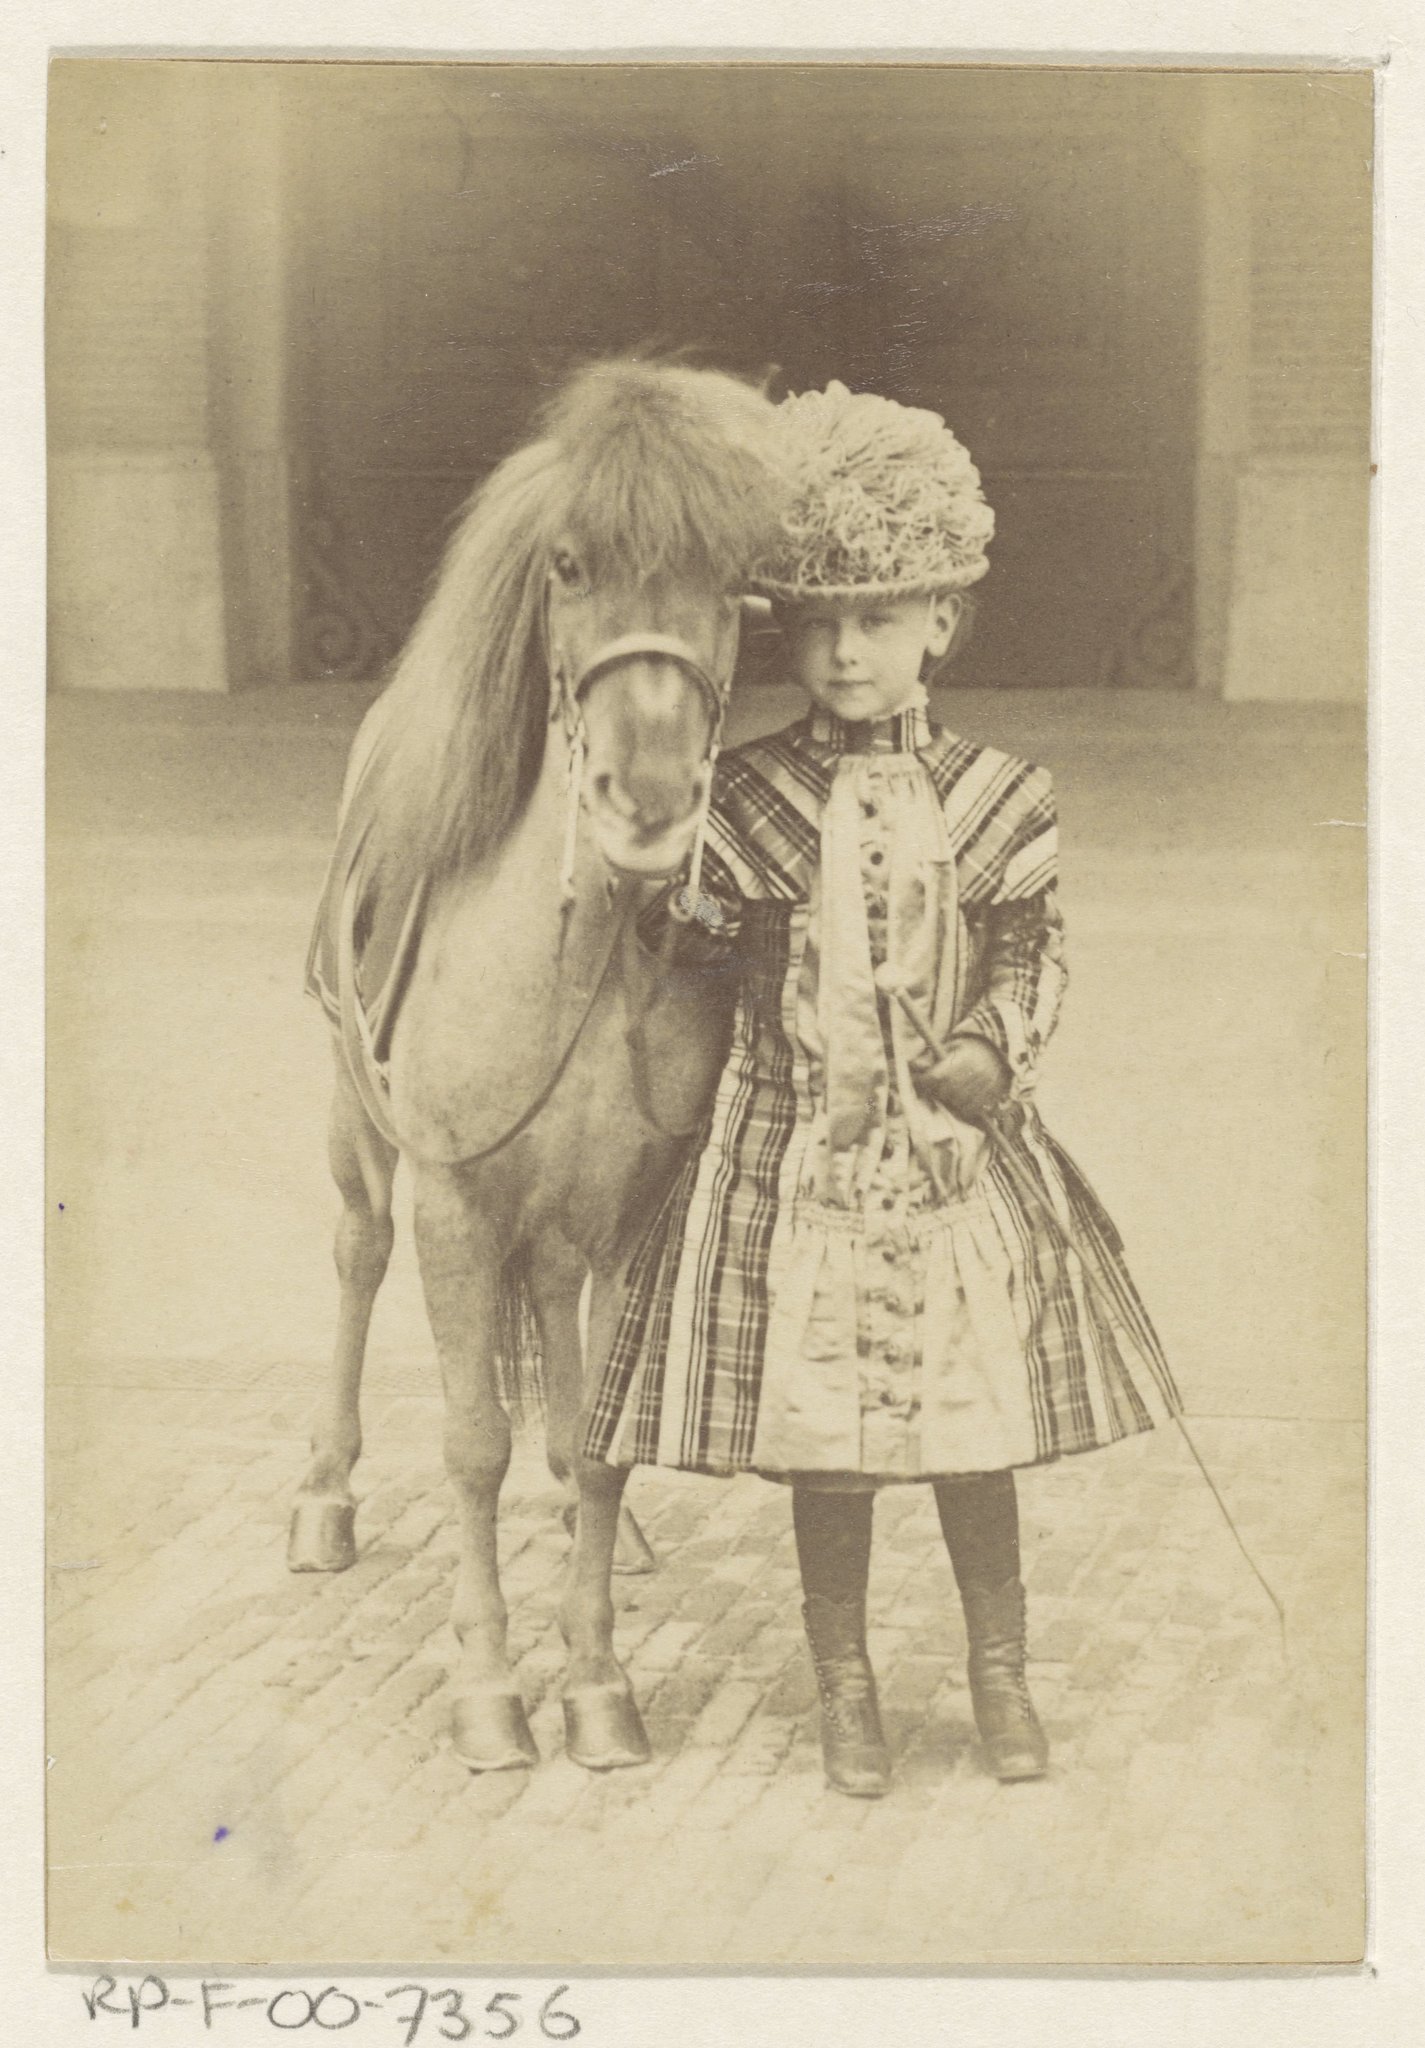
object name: photograph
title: Portret van Wilhelmina, koningin der Nederlanden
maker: Anonymous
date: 1887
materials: paper, photographic support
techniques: albumen print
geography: netherlands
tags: the hague, print maker, wilhelmina of the netherlands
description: De hier vermelde titel verwijst naar de hoogst verkregen titel van de geportretteerde, niet per se naar de titel die de geportretteerde op deze voorstelling draagt.